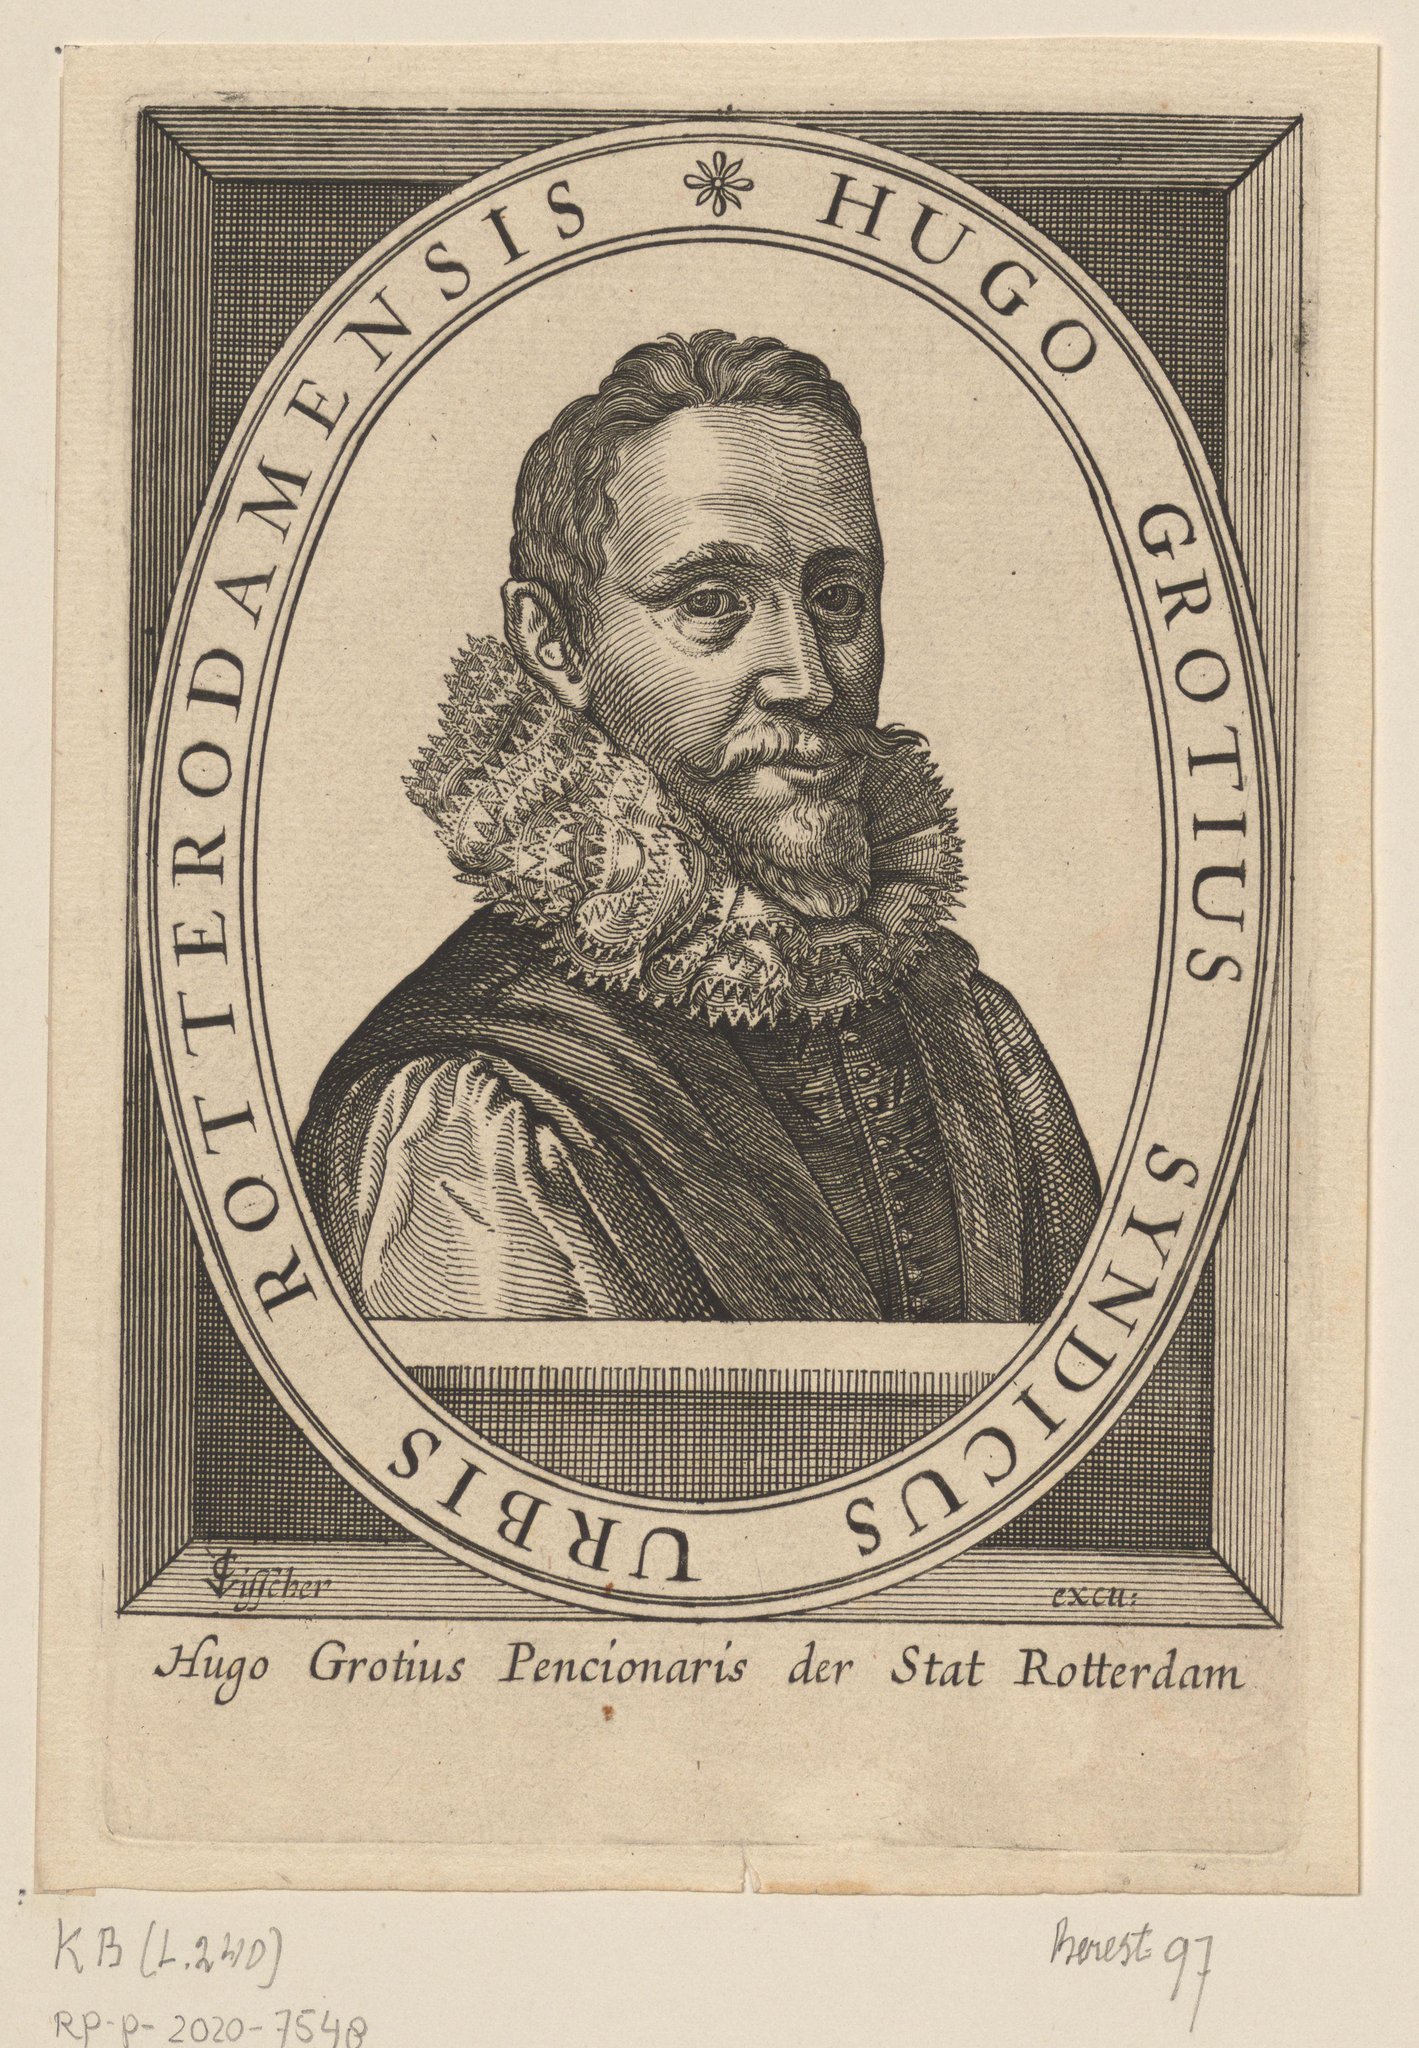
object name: book illustration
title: Portret van Hugo de Groot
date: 1619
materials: paper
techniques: engraving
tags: delft, hugo de groot, historical persons, portrait of a writer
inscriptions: collector's mark: Lugt 240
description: Prent uit: Sententie, uyt-ghesproocken ende ghepronuncieert over Hugo de Groot (...). Den Haag: Hillebrant Jacobsz. van Wouw, 1619, tegenover de titelpagina.